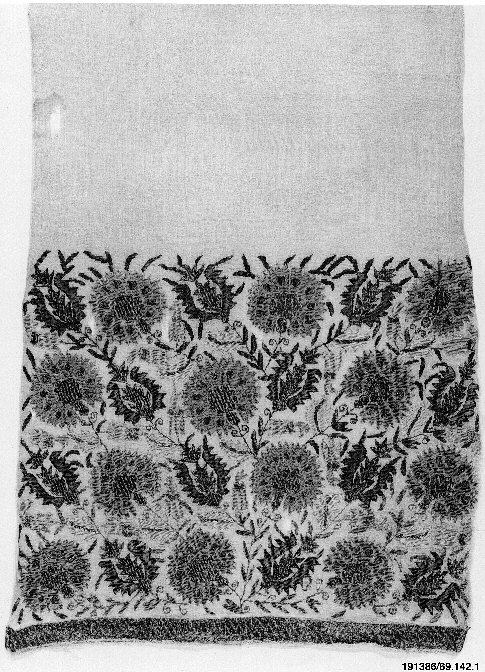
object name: towel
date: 1701-1800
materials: cotton, metal thread, silk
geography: turkey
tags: flowers